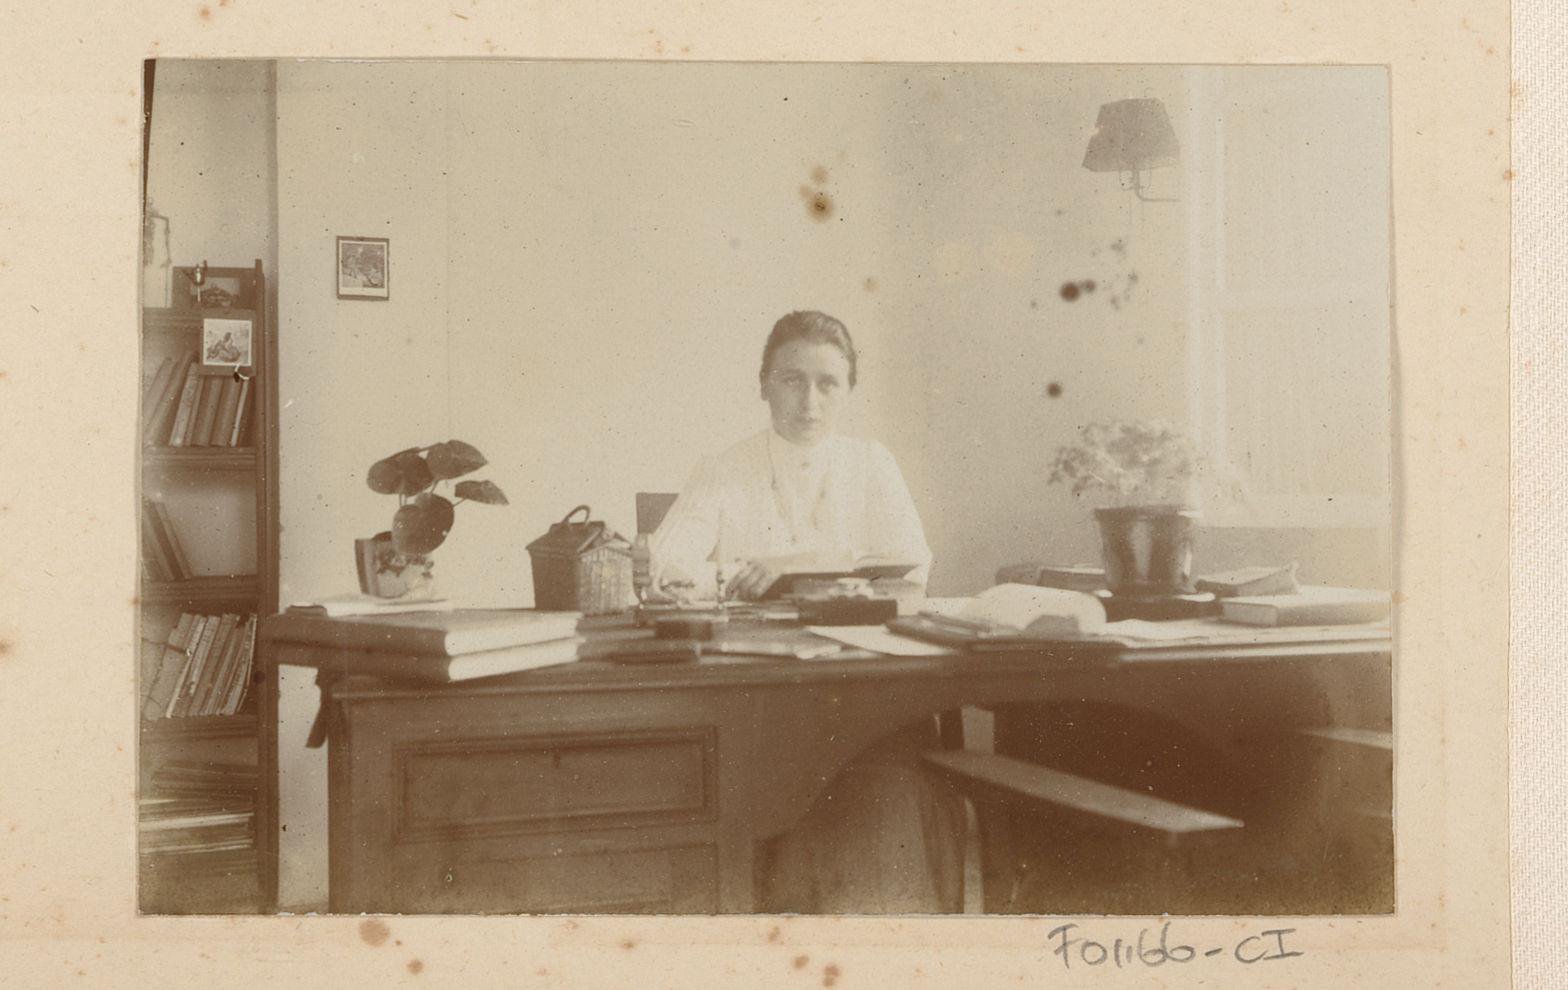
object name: album leaf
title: Vrouw zittend achter een bureau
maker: Anonymous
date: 1880-1910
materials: photographic support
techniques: gelatin silver print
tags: writing-table, writing-desk, sitting figure - aa - female human figure, historical persons, dutch east indies, the